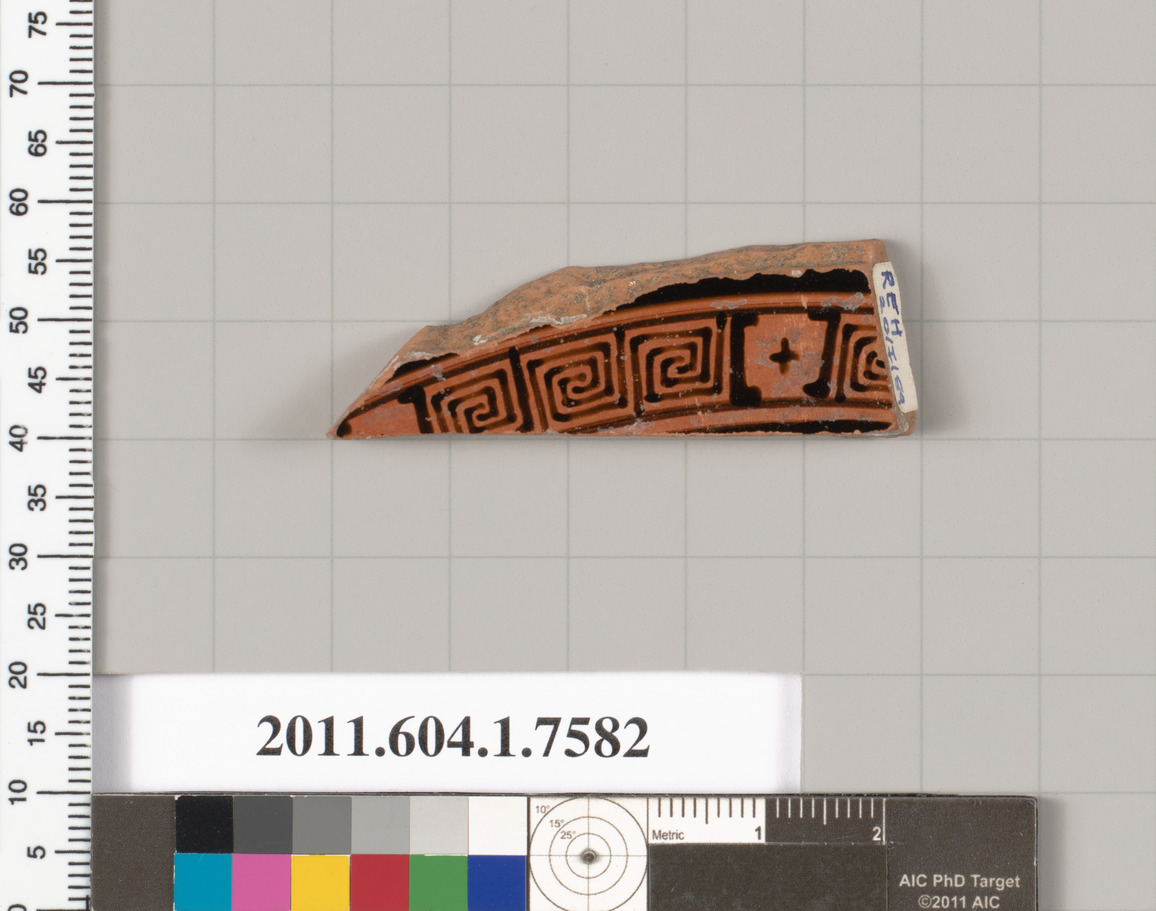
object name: kylix fragment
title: Terracotta fragment of a kylix (drinking cup)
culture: greek, attic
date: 460-450 BCE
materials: terracotta